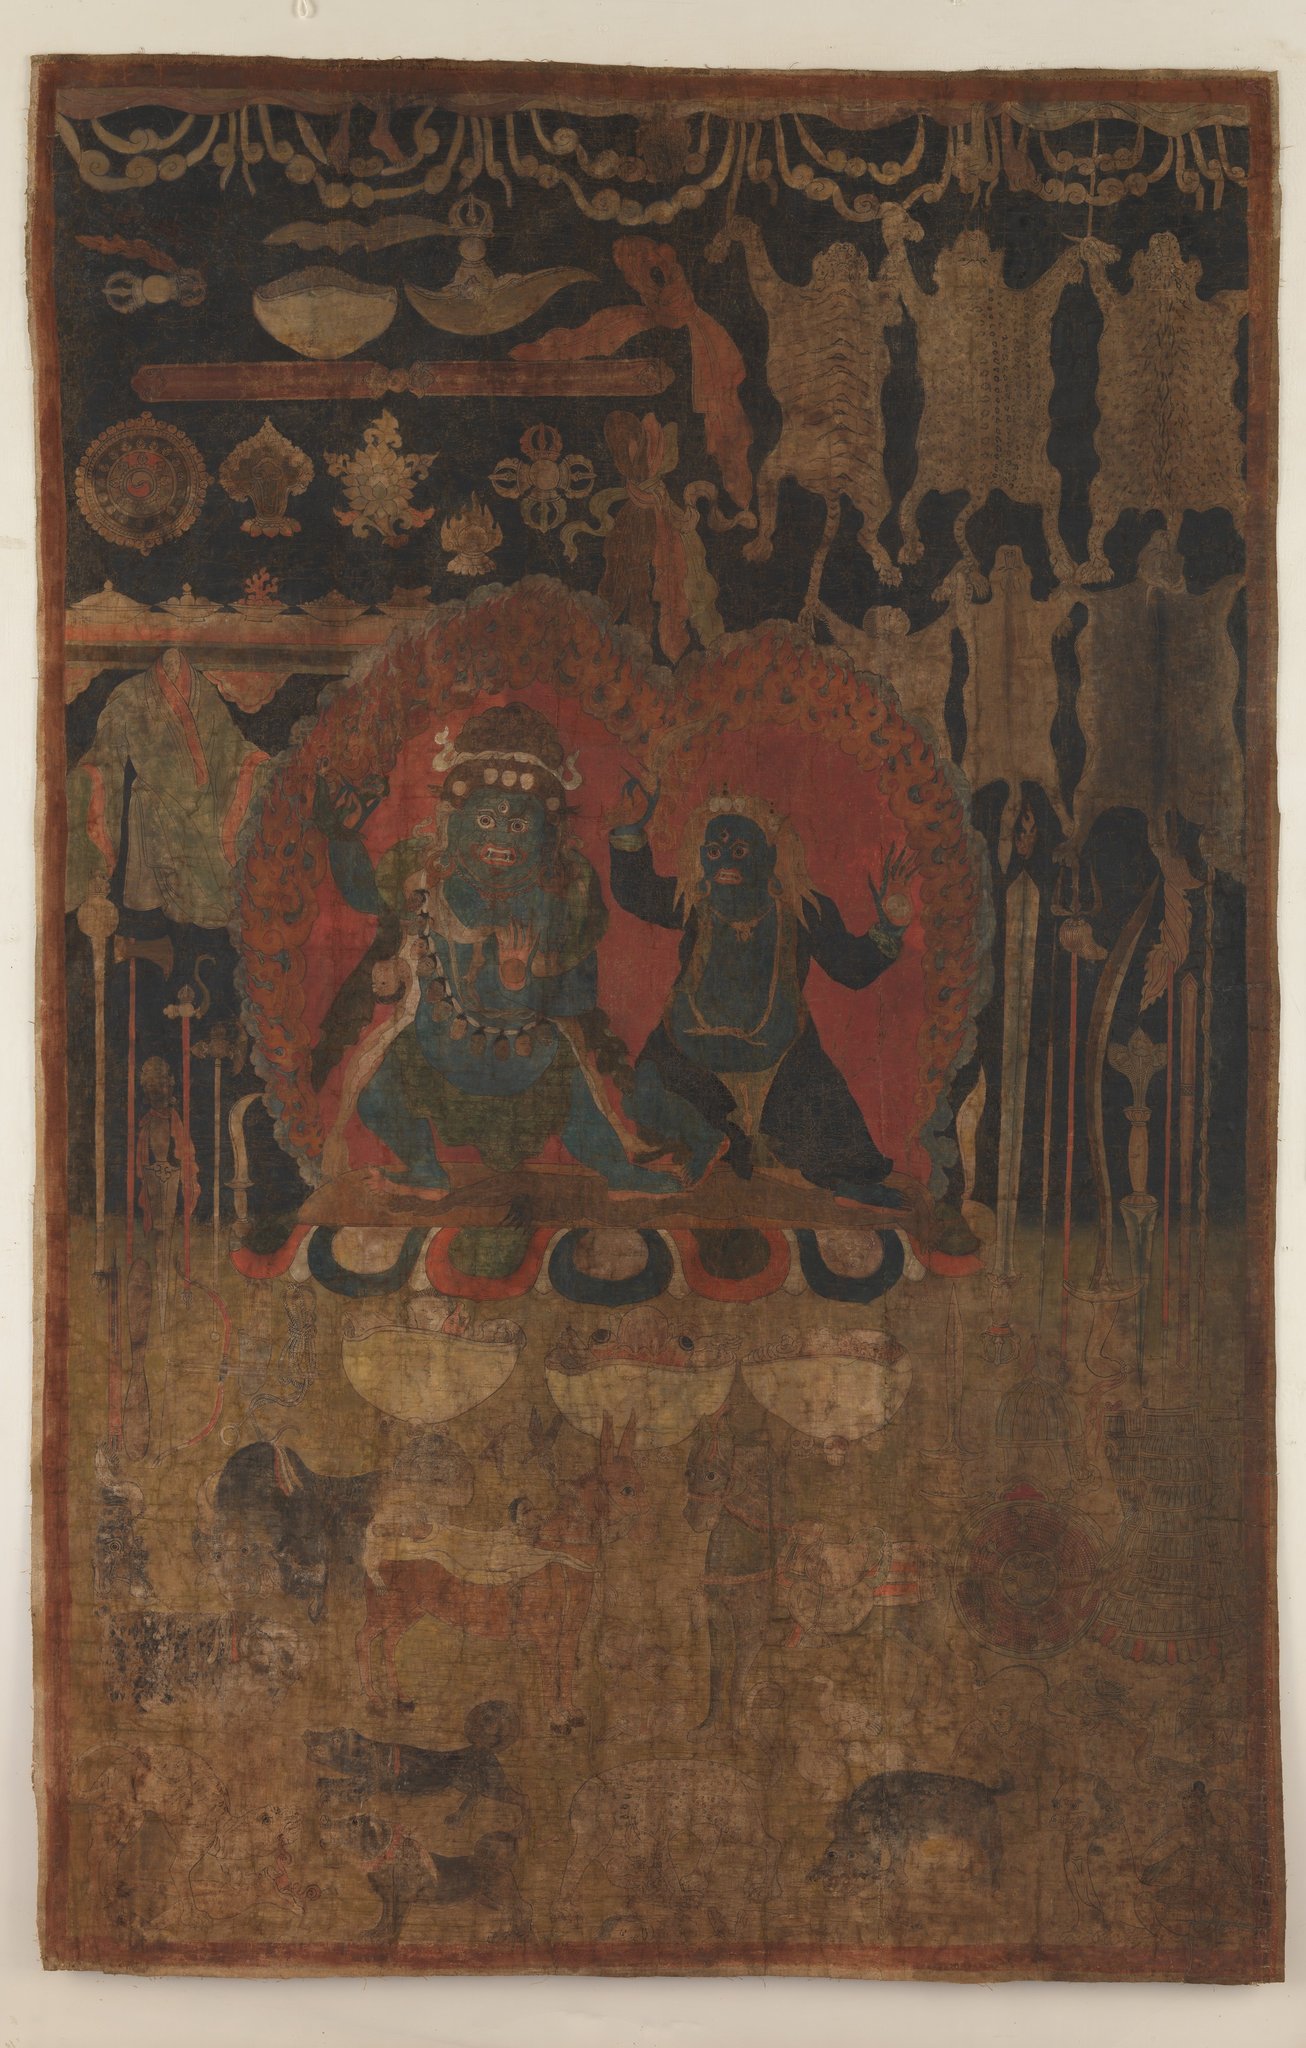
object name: thangka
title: Offerings to Wrathful Deities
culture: tibetan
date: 1567-1700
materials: textile, ink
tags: buddhism,gods